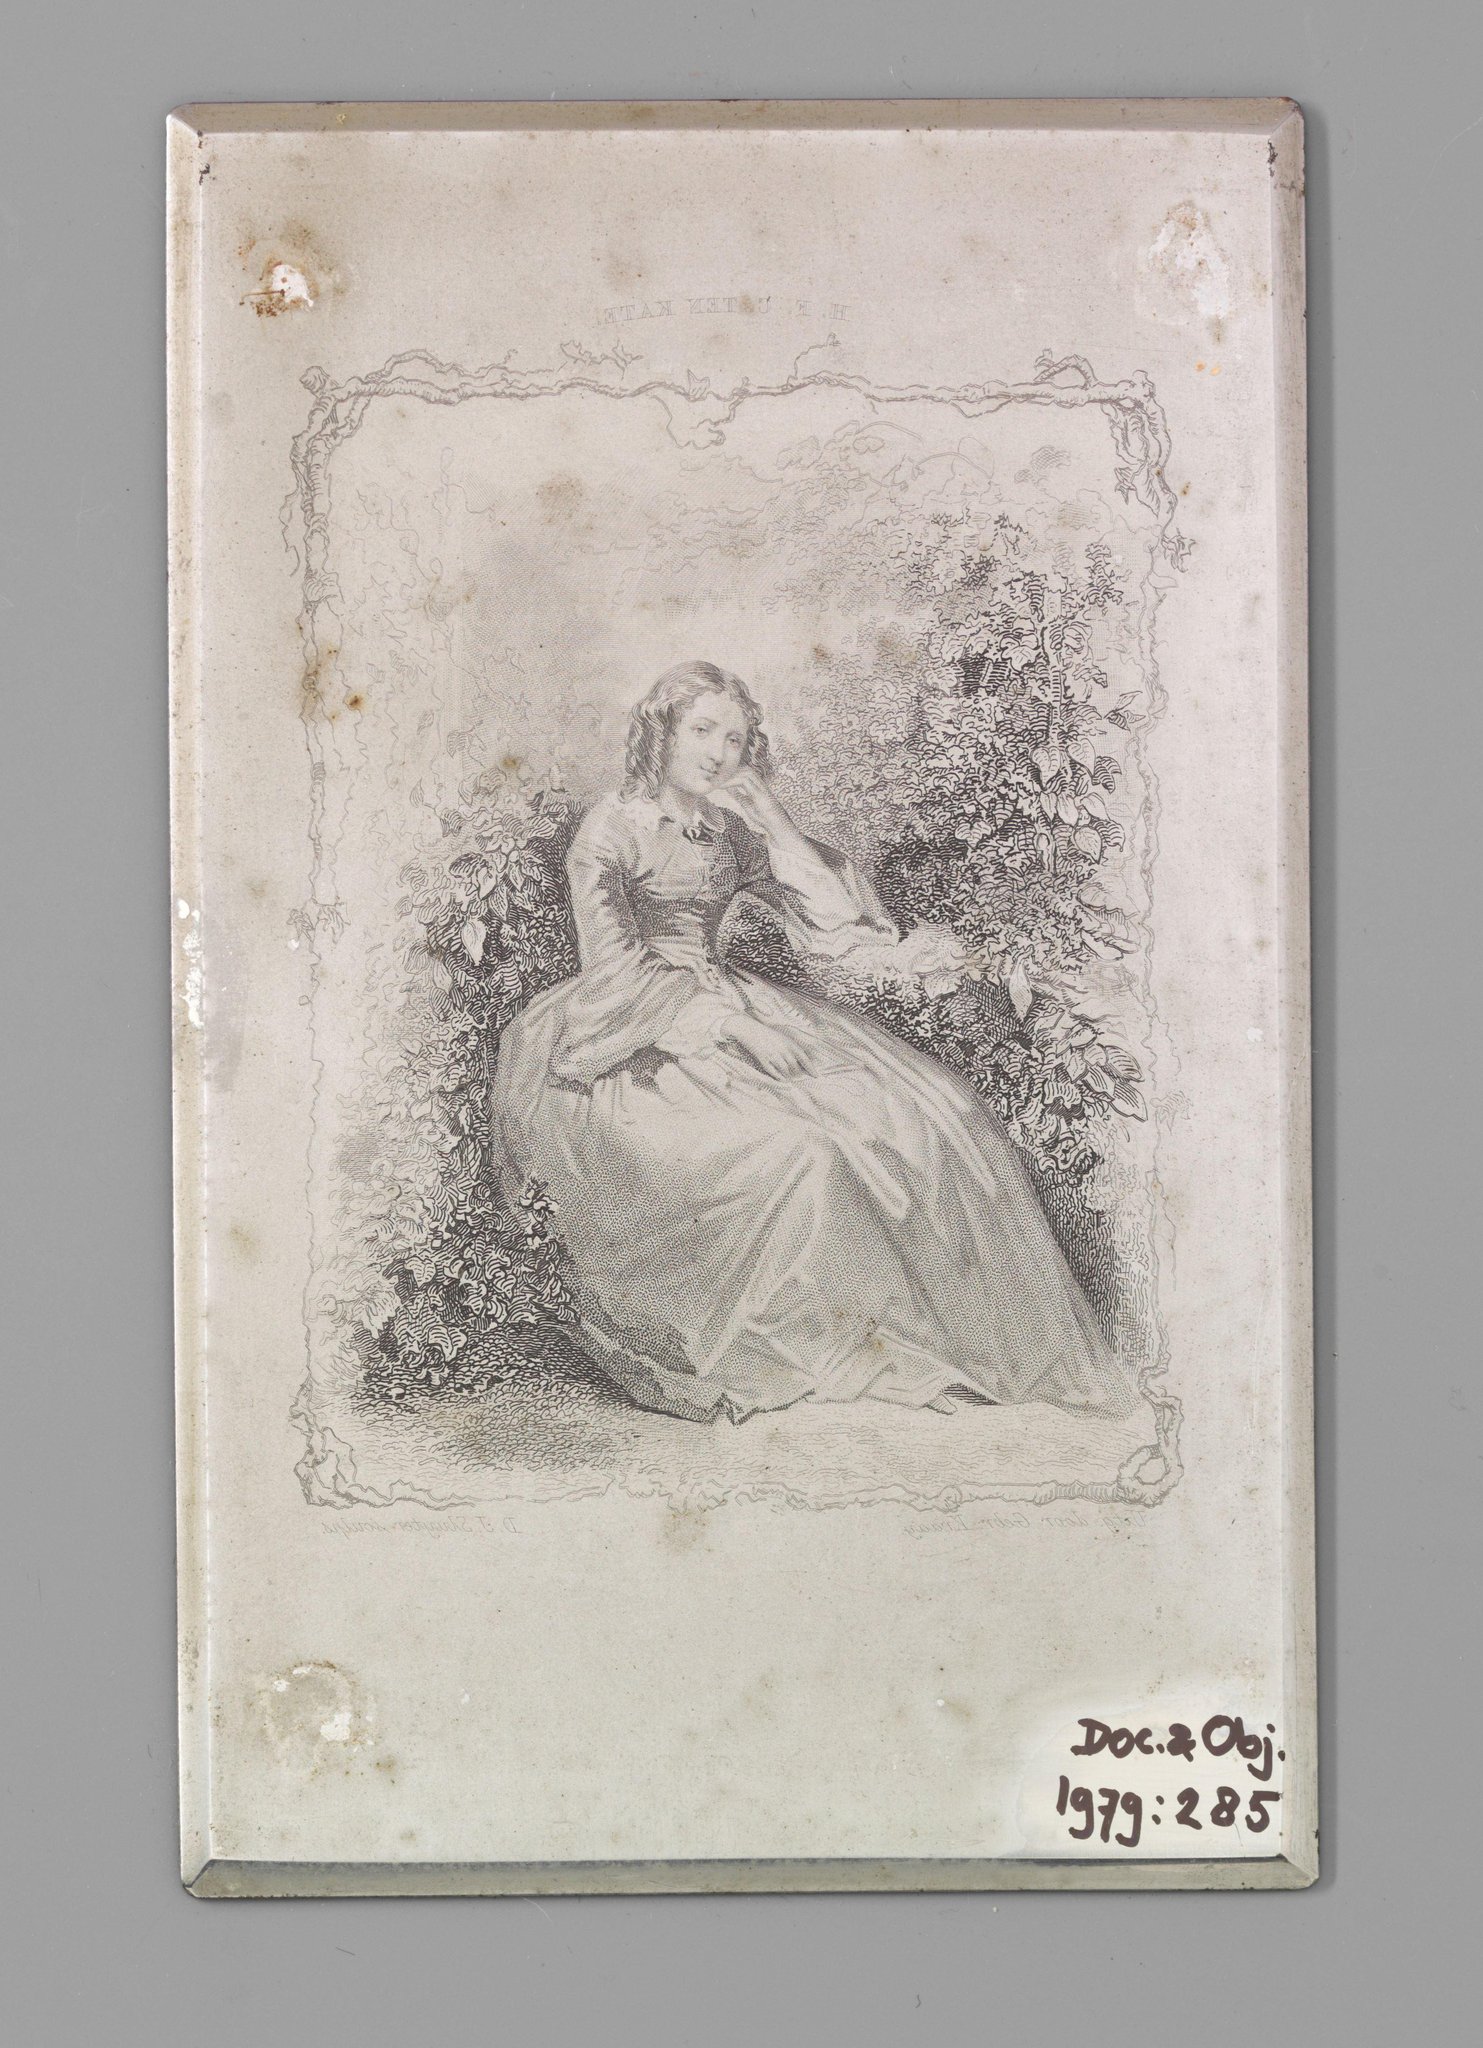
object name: staalplaat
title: Peinzende vrouw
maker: dirk jurriaan sluyter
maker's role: draughtsman, print maker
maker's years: 1811-1886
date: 1832-1870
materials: steel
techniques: engraving